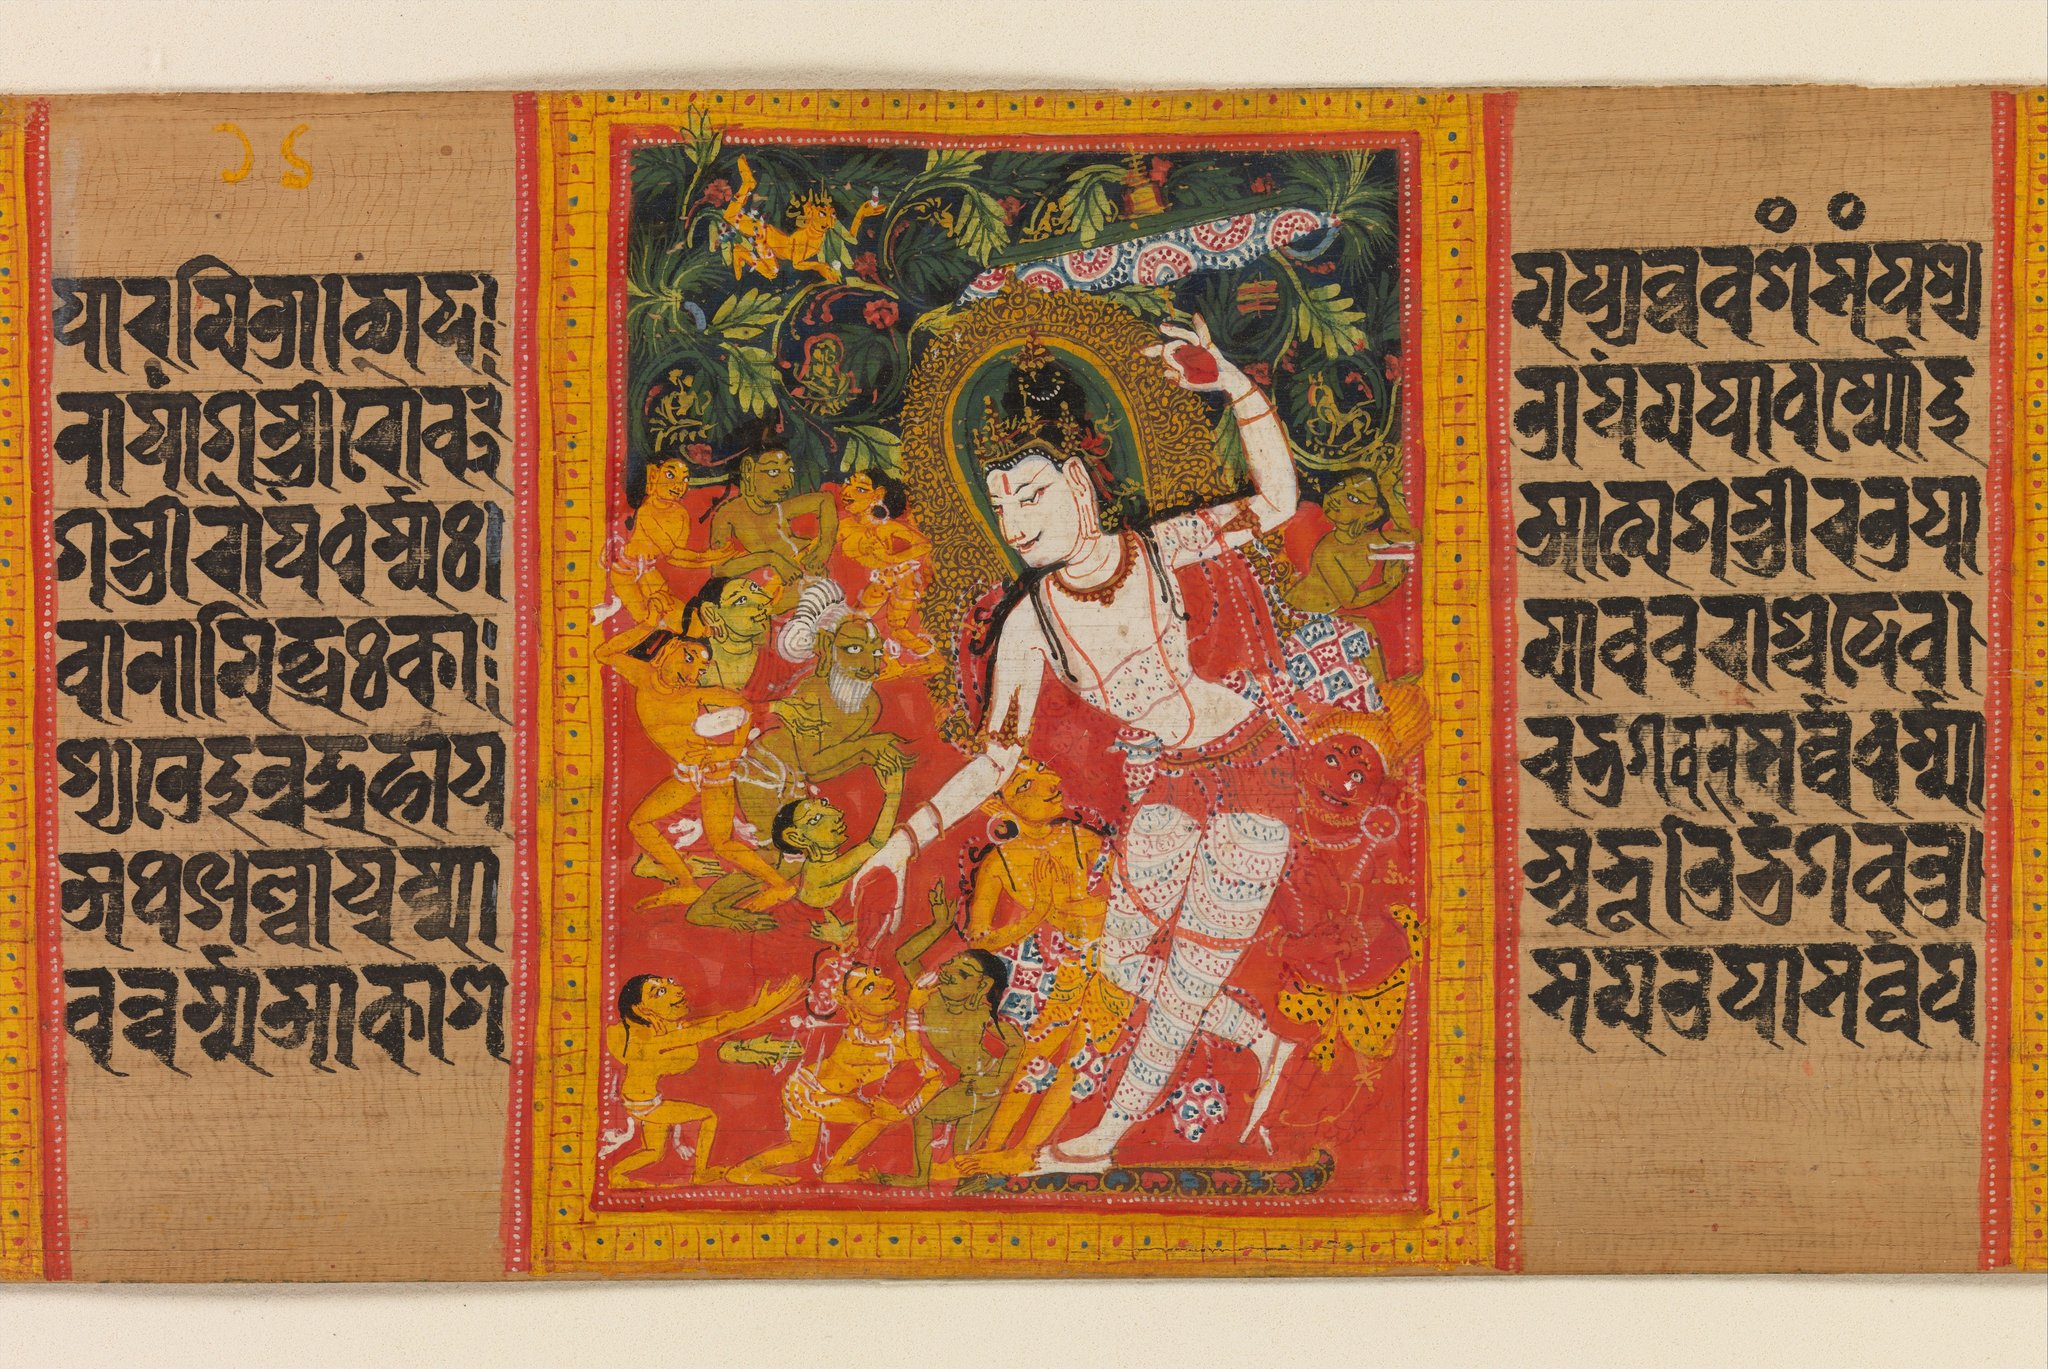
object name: folio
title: The Bodhisattva Avalokiteshvara Dispensing Boons: Folio from an Ashtasahasrika Prajnaparamita Manuscript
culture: indian or west bengali or bangladeshi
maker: mahavihara master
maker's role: artist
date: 1101-1133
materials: leaf, watercolor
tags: buddhism,avalokiteshvara,bodhisattvas